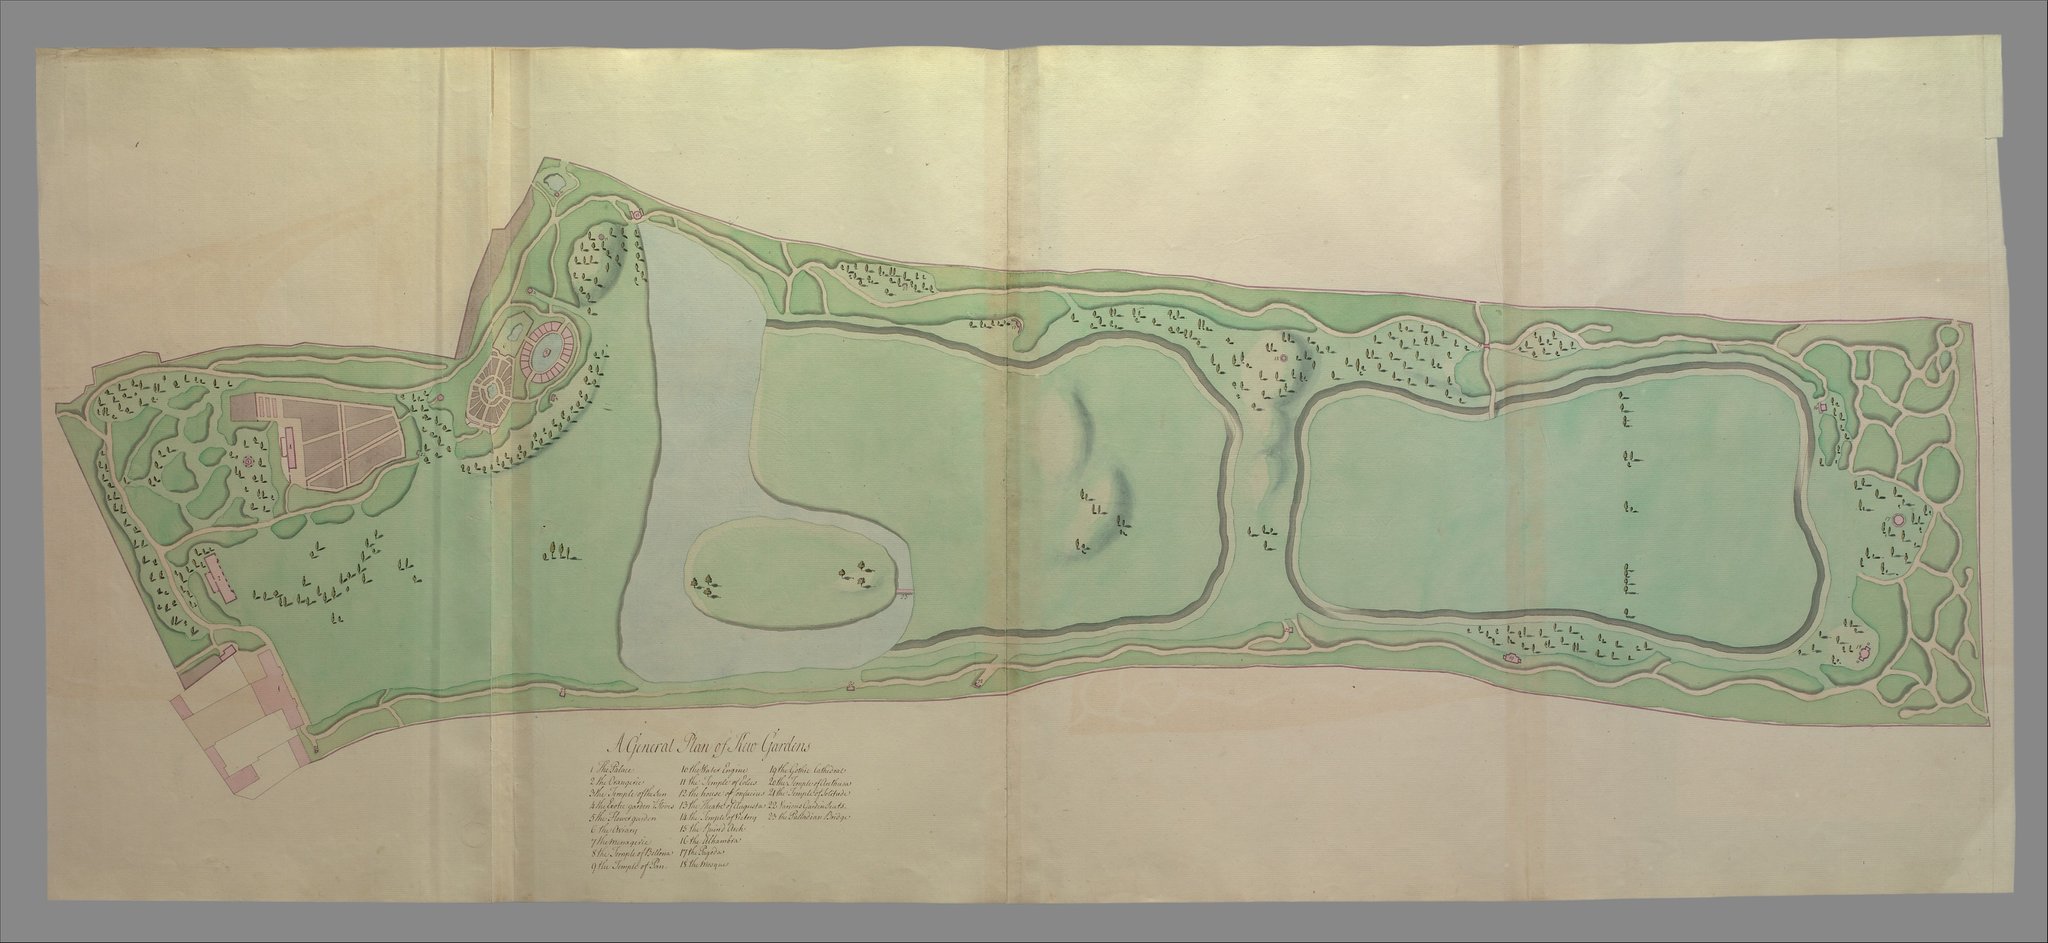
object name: drawing ornament architecture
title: General Plan of the Gardens at Kew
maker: sir william chambers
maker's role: architect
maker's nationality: british, born sweden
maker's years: 1723-1796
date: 1763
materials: ink, watercolor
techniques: pen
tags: gardens